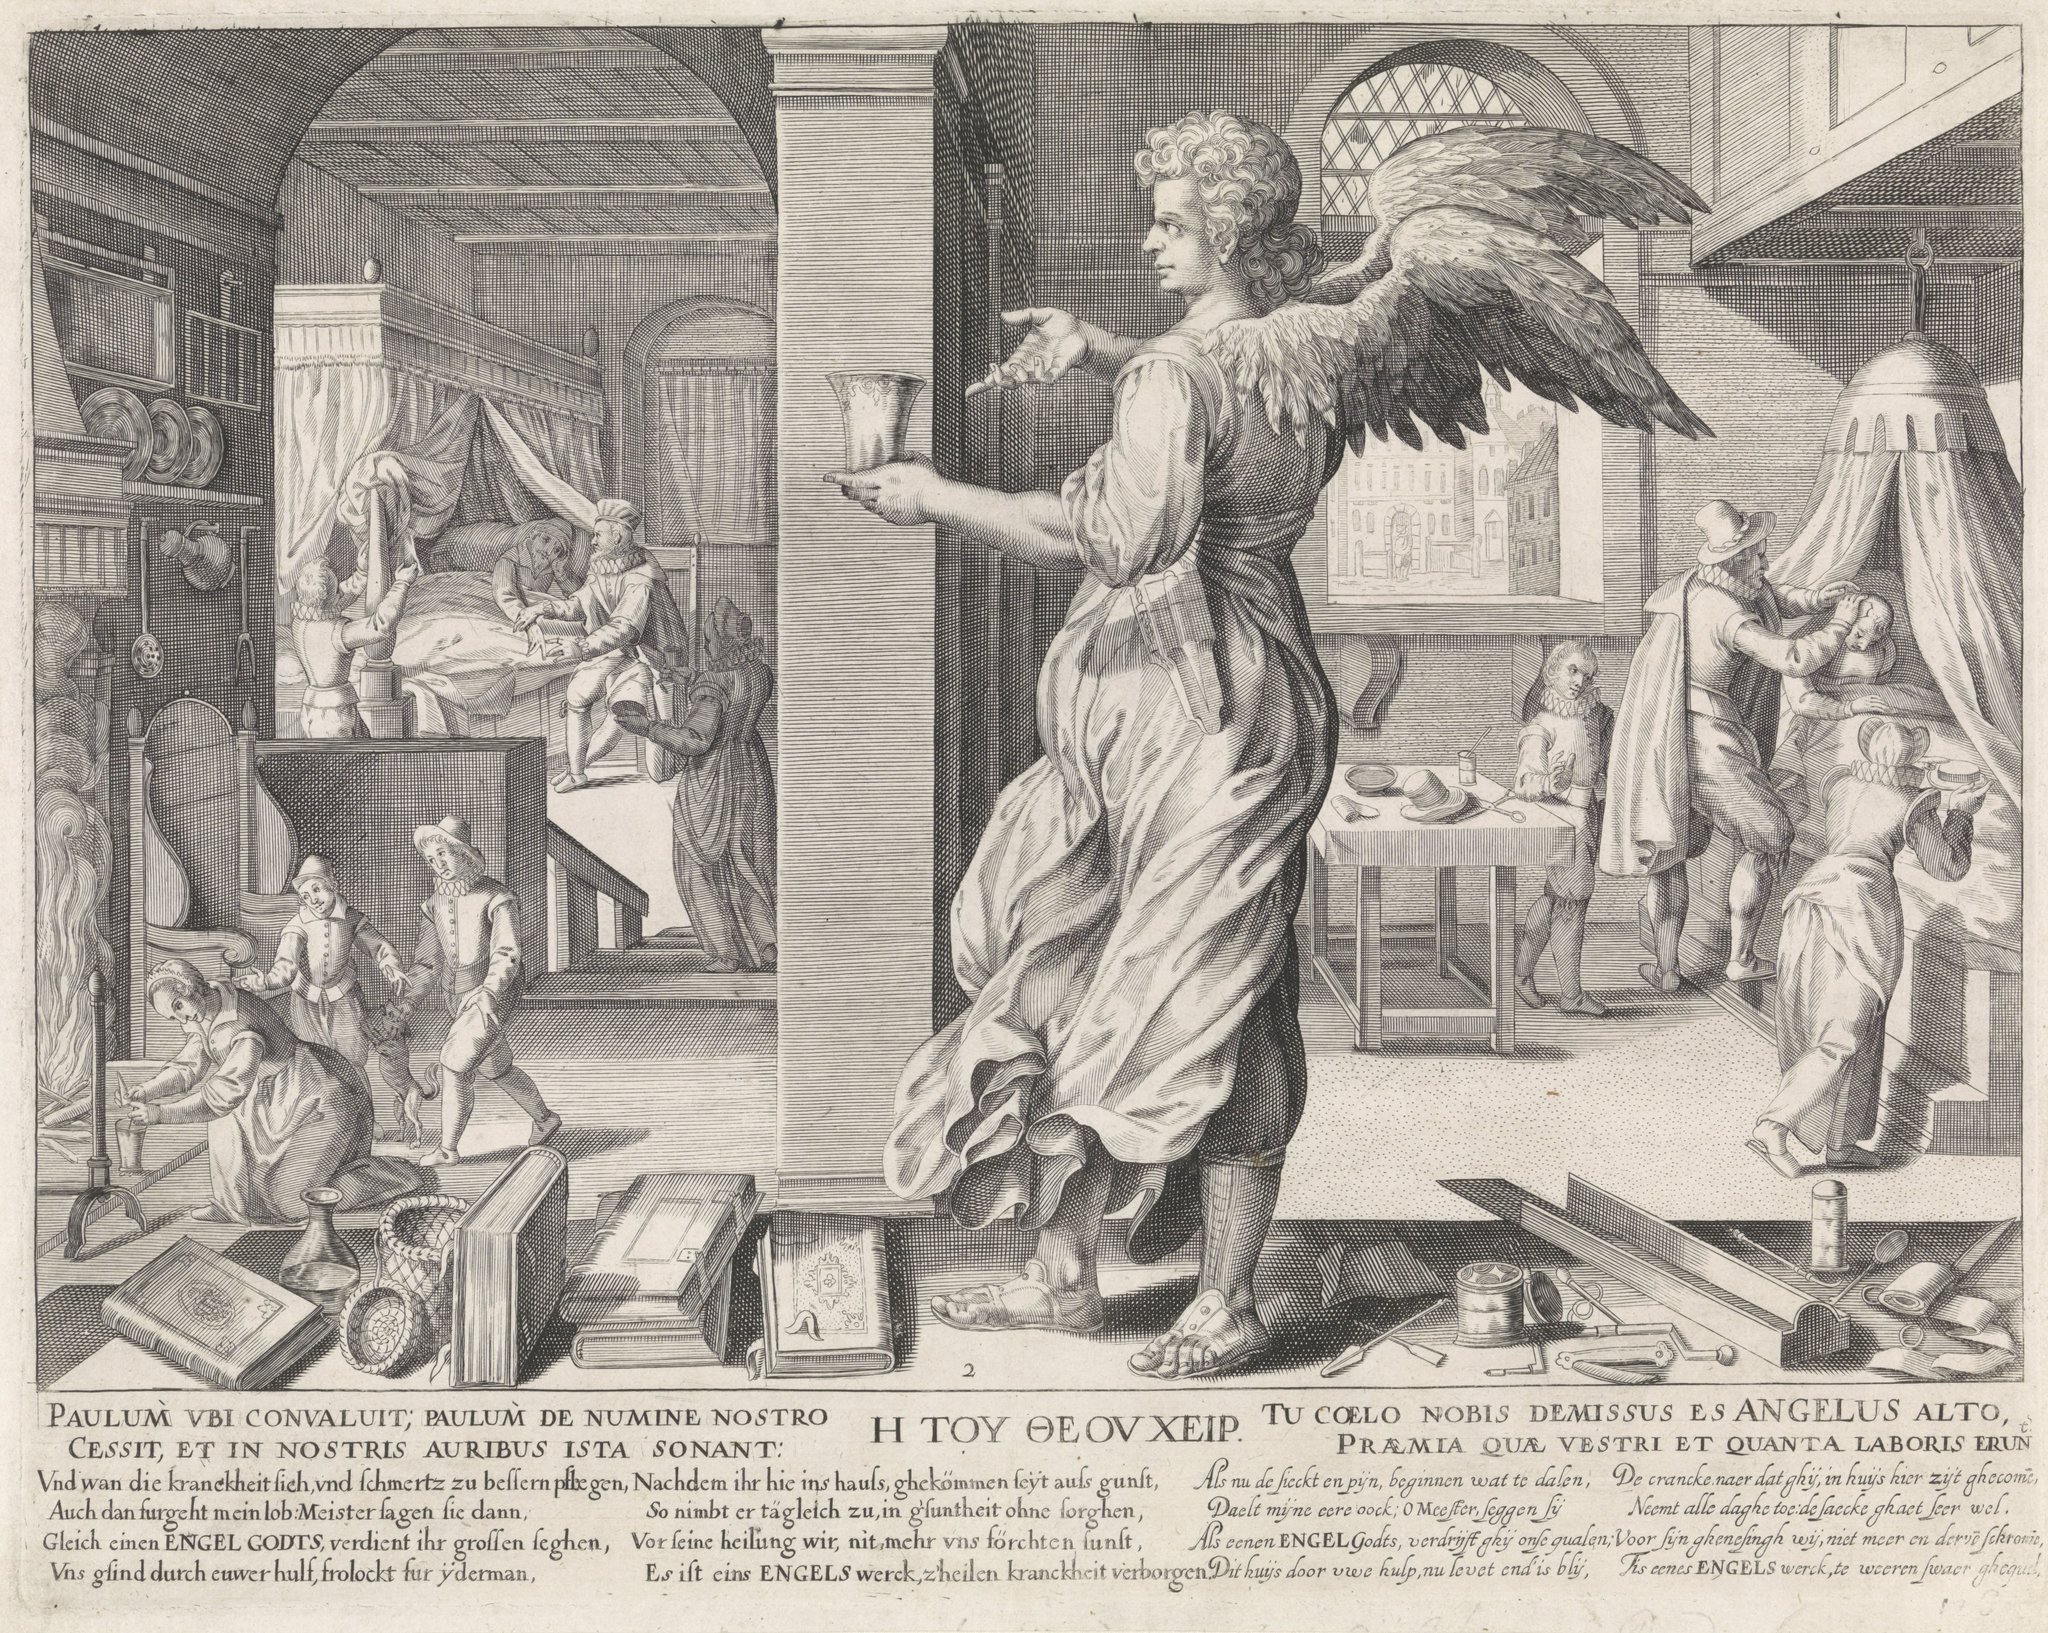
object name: print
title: De vier gedaantes van de geneesheer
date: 1609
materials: paper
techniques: engraving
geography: antwerp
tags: guardian angel, physician, doctor, patient, sick person, medicine, medical science, medical examination, medical treatment, medicament, medicine, medicine, medical science (+ tools, instruments; laboratory equipment ~ scientific research)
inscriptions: collector's mark: Lugt 2228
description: In het midden een engel die een beker medicijn in zijn hand heeft. Rondom hem liggen de instrumenten van de geneeskunde. Op de achtergrond het interieur van een woonhuis. Links verzorgt een geneesheer een zieke patiënt. Rechts onderzoekt hij hem. Wanneer een zieke geneest, wordt een geneesheer beschouwd als een reddende engel. De prent heeft een Latijns, Duits en Nederlands onderschrift en maakt deel uit van een vierdelige serie over de gedaantes van de geneesheer.